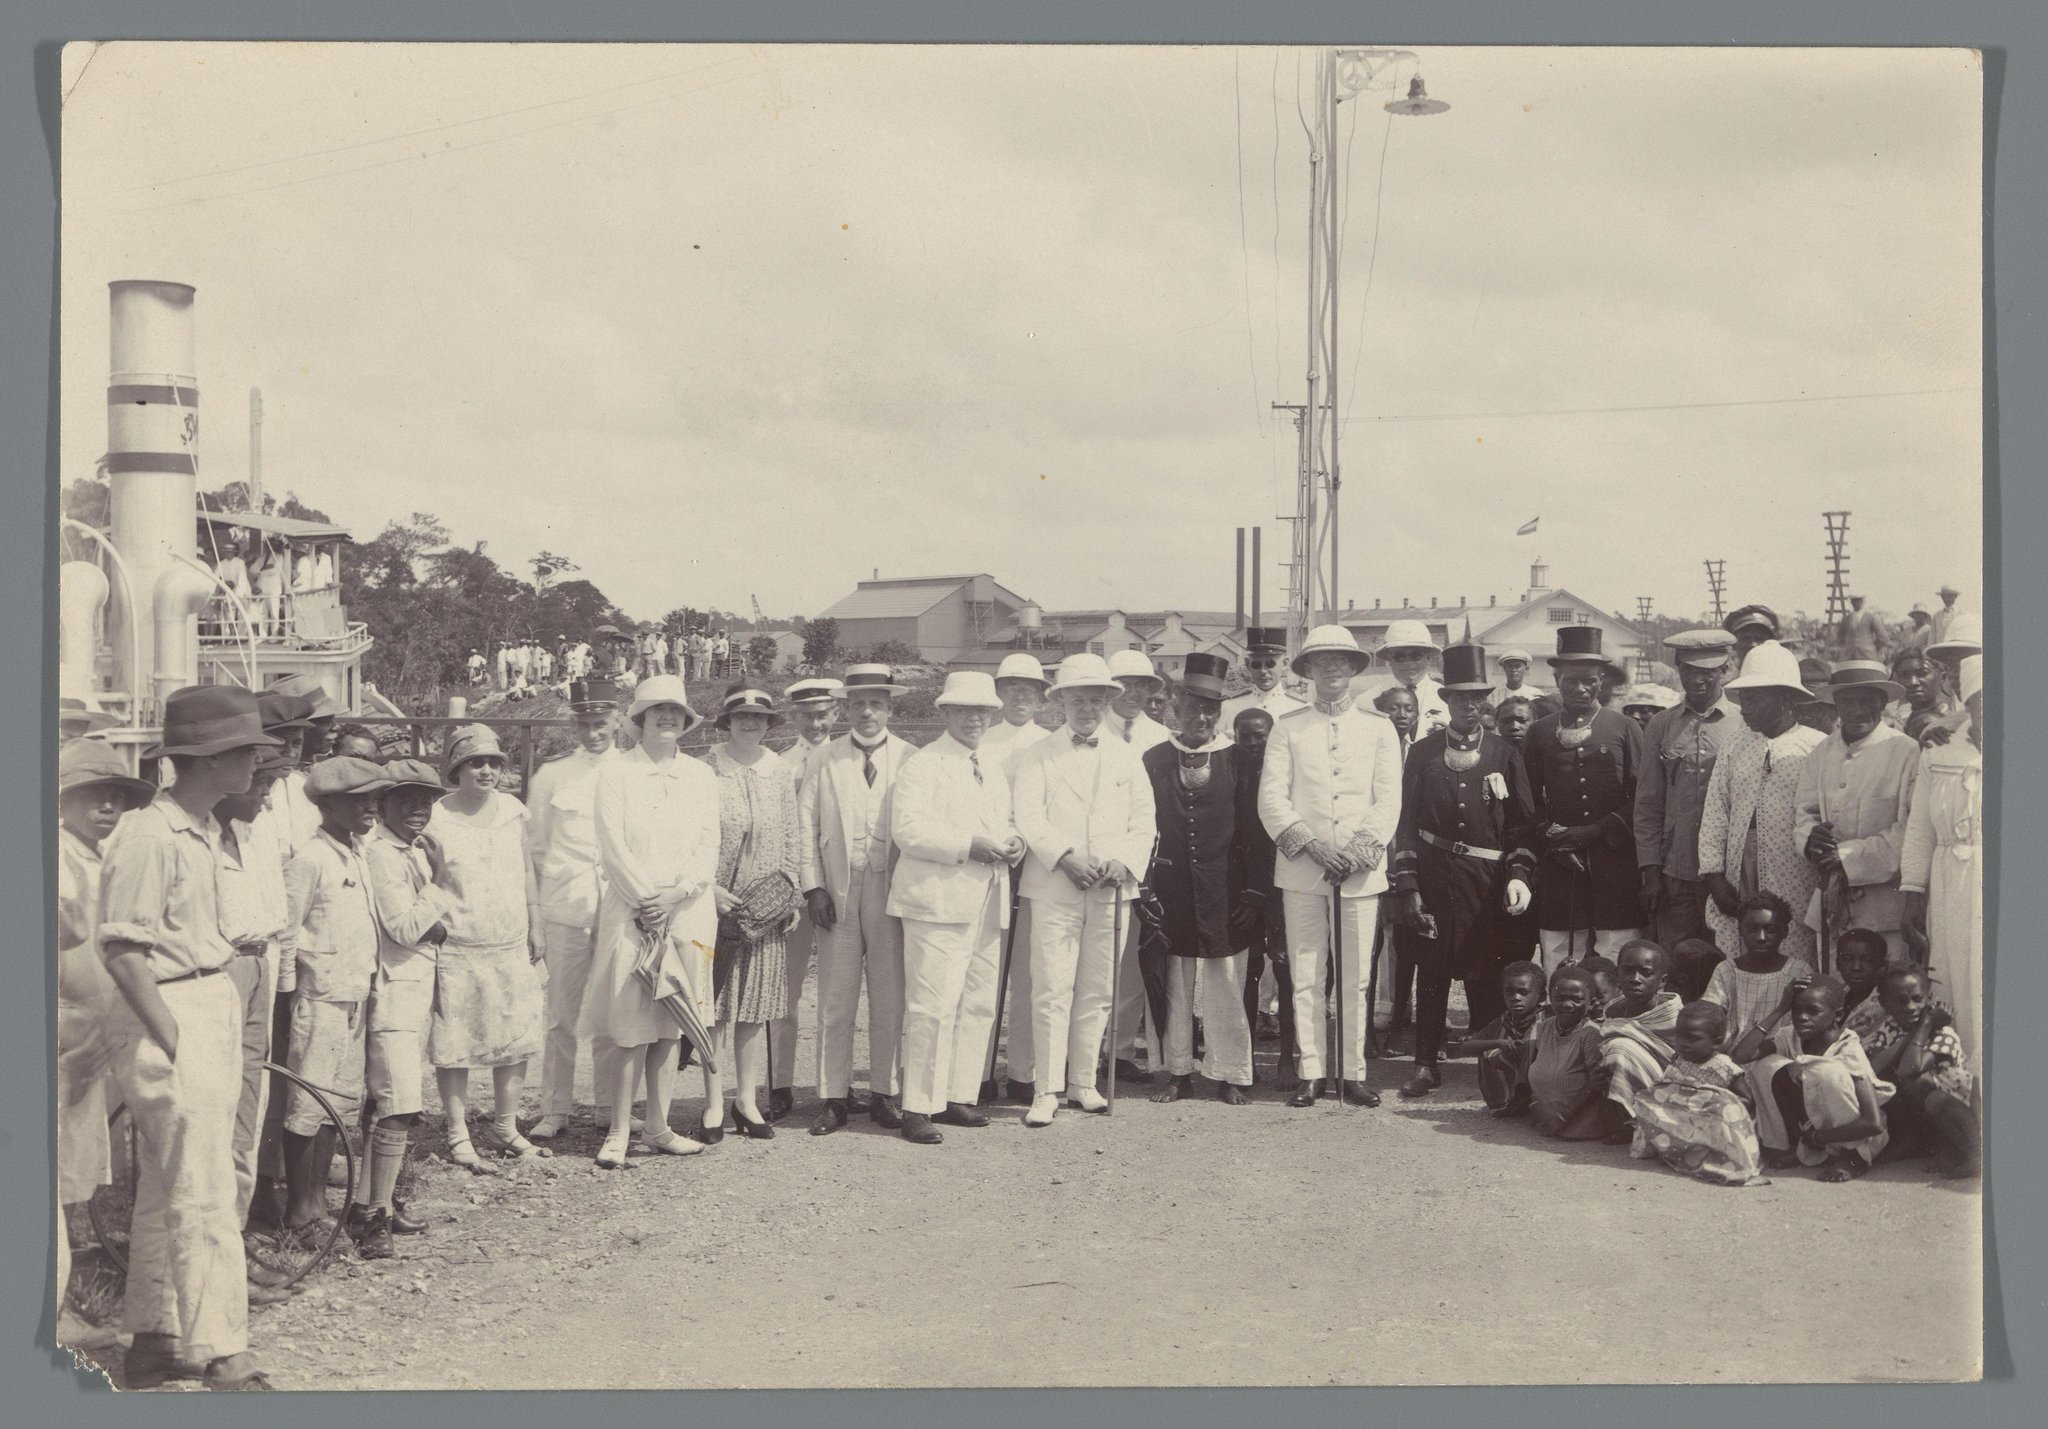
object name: ansichtkaart, prentbriefkaart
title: Ensemble ingenieur Jetten en familie in Moengo, Suriname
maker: Anonymous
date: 1925-1927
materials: paper, photographic support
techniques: photography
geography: suriname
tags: jetten, familie, moengo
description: Ensemble bestaande uit 35 losse foto's, 26 losse albumbladen met foto's en 1 ansichtkaart met (familie)foto's, die het leven en werken tonen in de mijnstad Moengo in Suriname. De ansichtkaart is gericht aan mevrouw Jetten en is afkomstig van de fotografe Augusta Curiel, de belangrijkste Surinaamse fotografe uit deze periode.